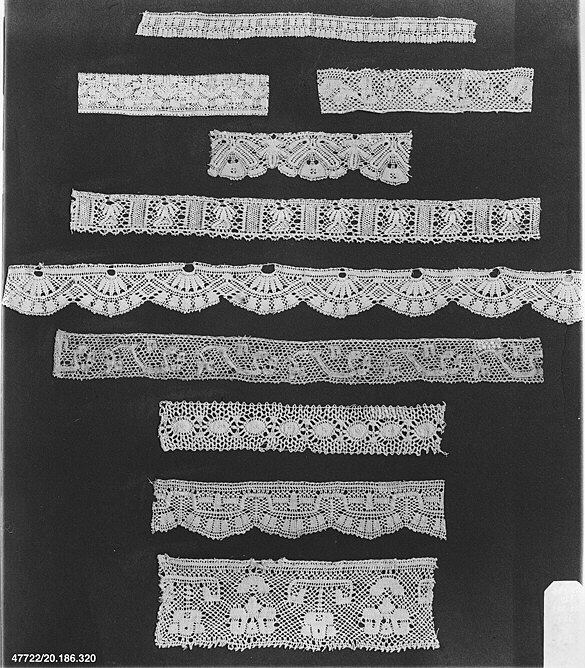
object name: edging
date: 1701-1800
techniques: lace